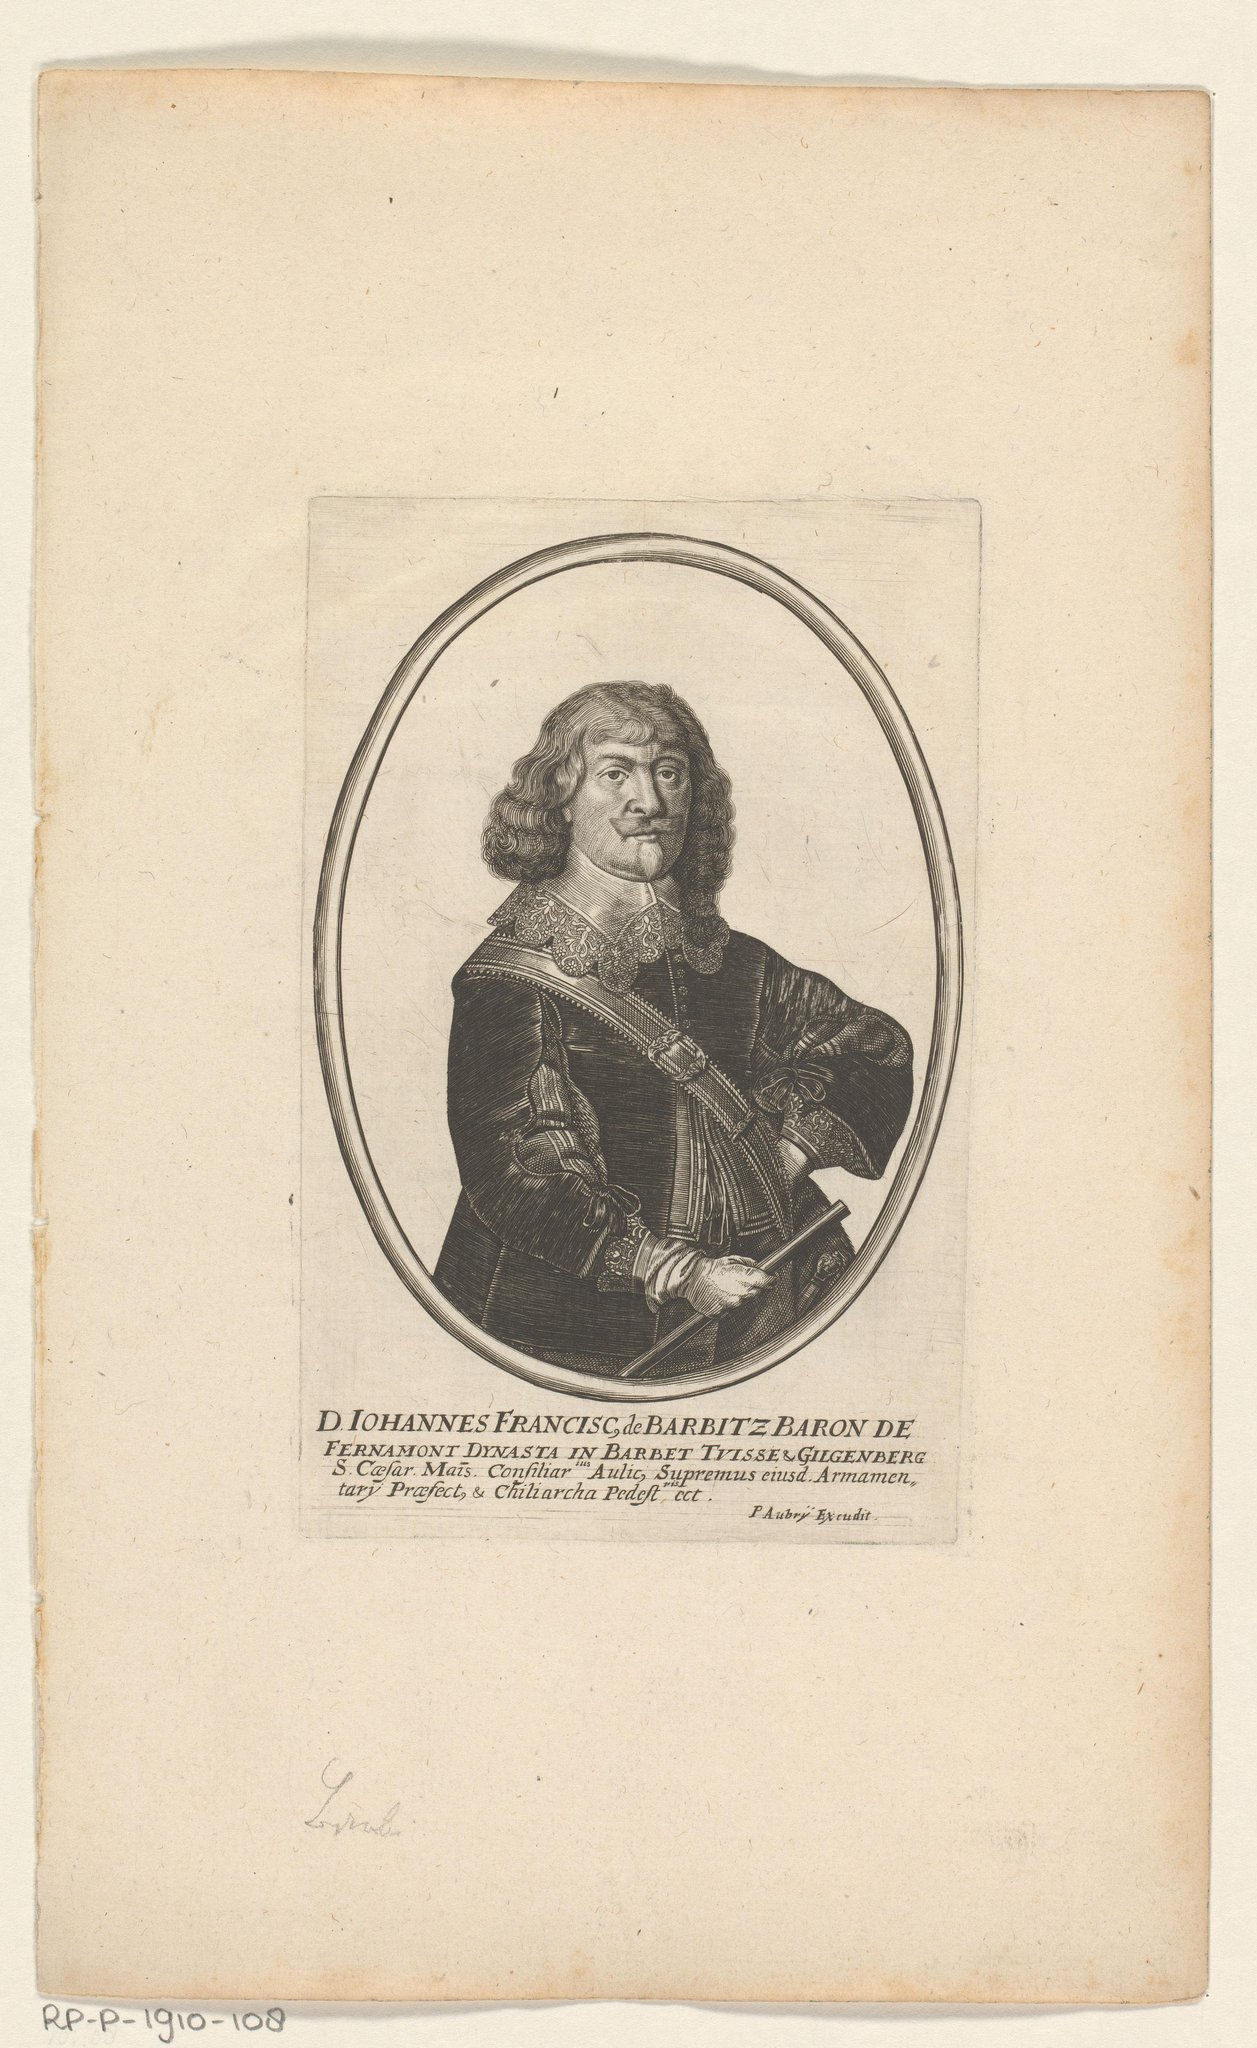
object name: print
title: Portret van Johan Frans van Barbitz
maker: Anonymous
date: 1637-1686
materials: paper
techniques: engraving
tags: historical persons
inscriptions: collector's mark: Lugt 2228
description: Met vierregelig onderschrift in het Latijn.